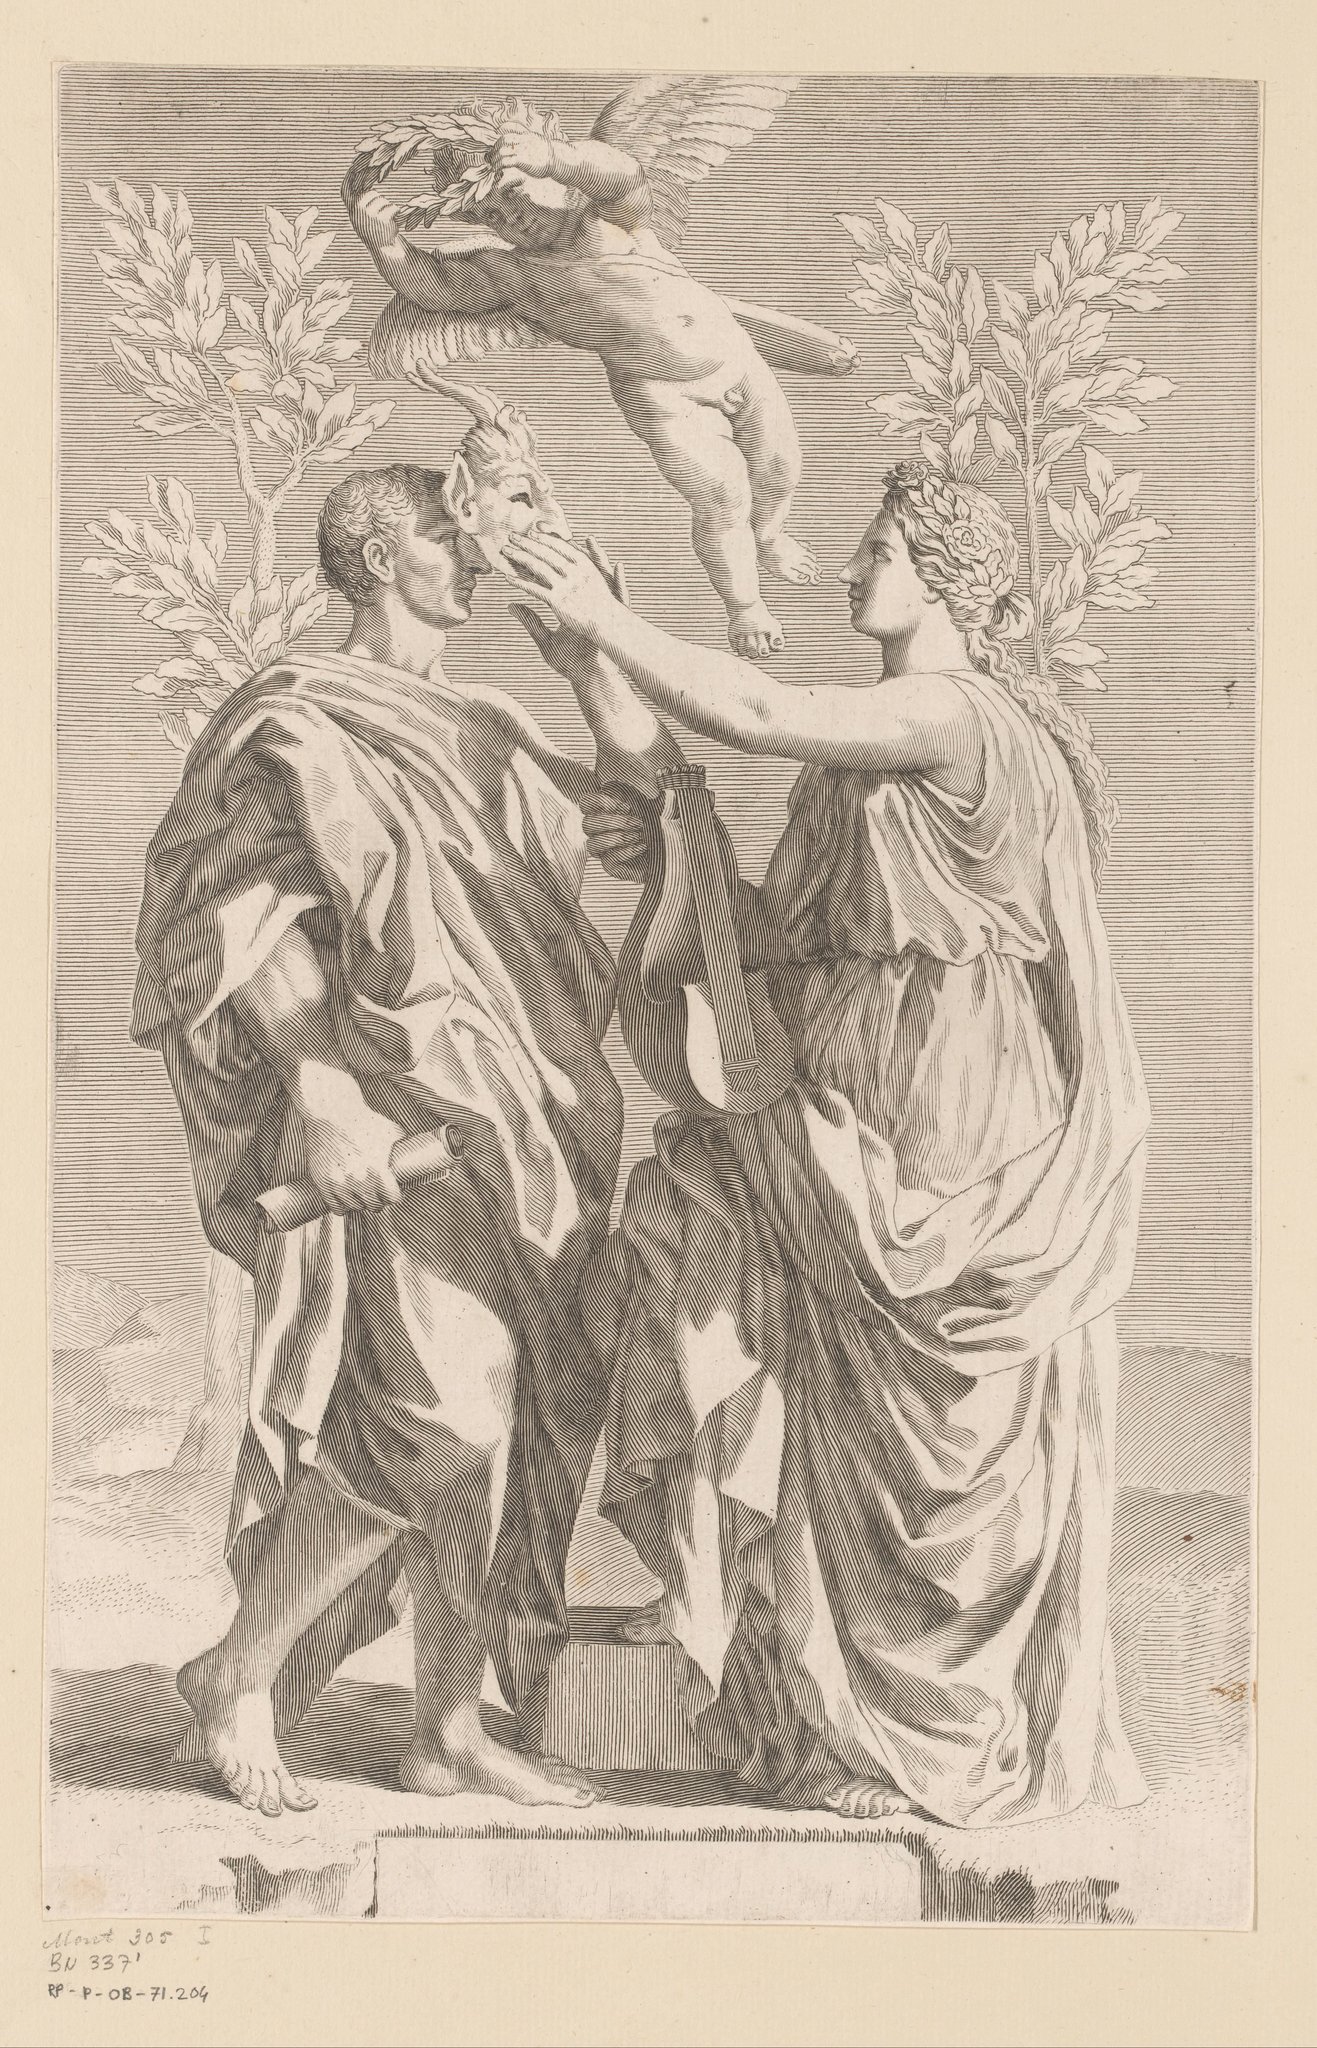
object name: titelblad, titelpagina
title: Muze zet Horatius een satyrmasker op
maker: claude mellan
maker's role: draughtsman, print maker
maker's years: 1598-1688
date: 1642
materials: paper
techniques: engraving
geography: paris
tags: horatius, mask, historical persons, single muses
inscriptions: collector's mark: Lugt 240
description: Titelpagina voor: Horatius. Quinti Horatii Flacci Opera. Parijs: Imprimerie Royale, 1642.